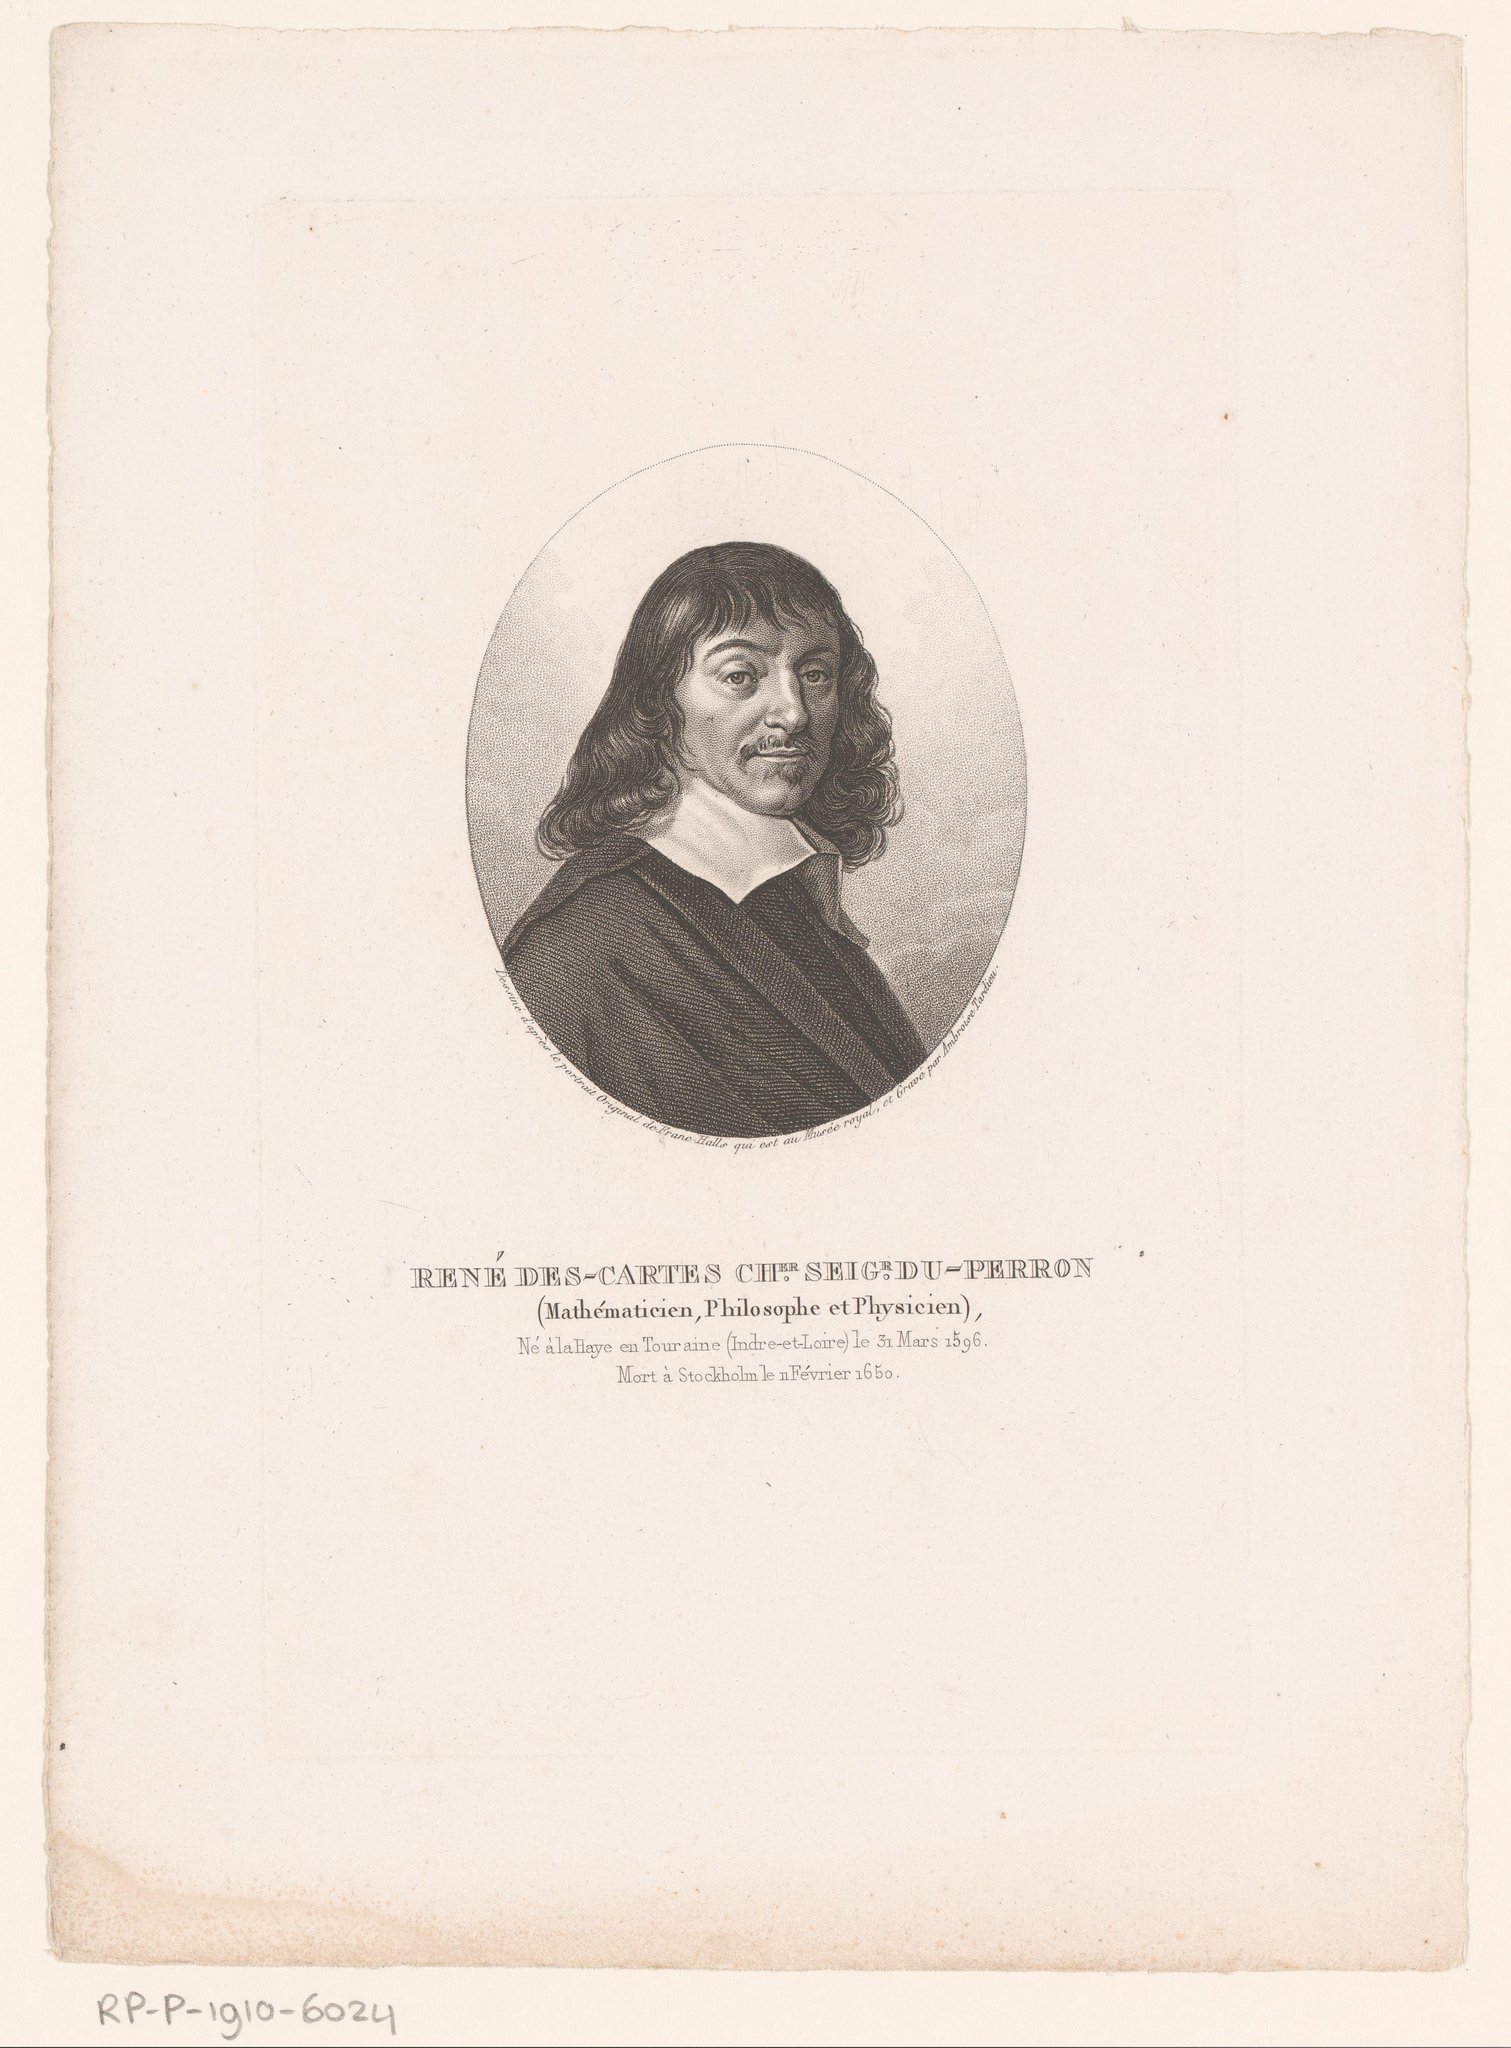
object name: print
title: Portret van René Descartes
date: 1798-1841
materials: paper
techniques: engraving, roulette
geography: paris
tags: rené descartes, scholar, philosopher, historical persons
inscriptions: collector's mark: Lugt 2228